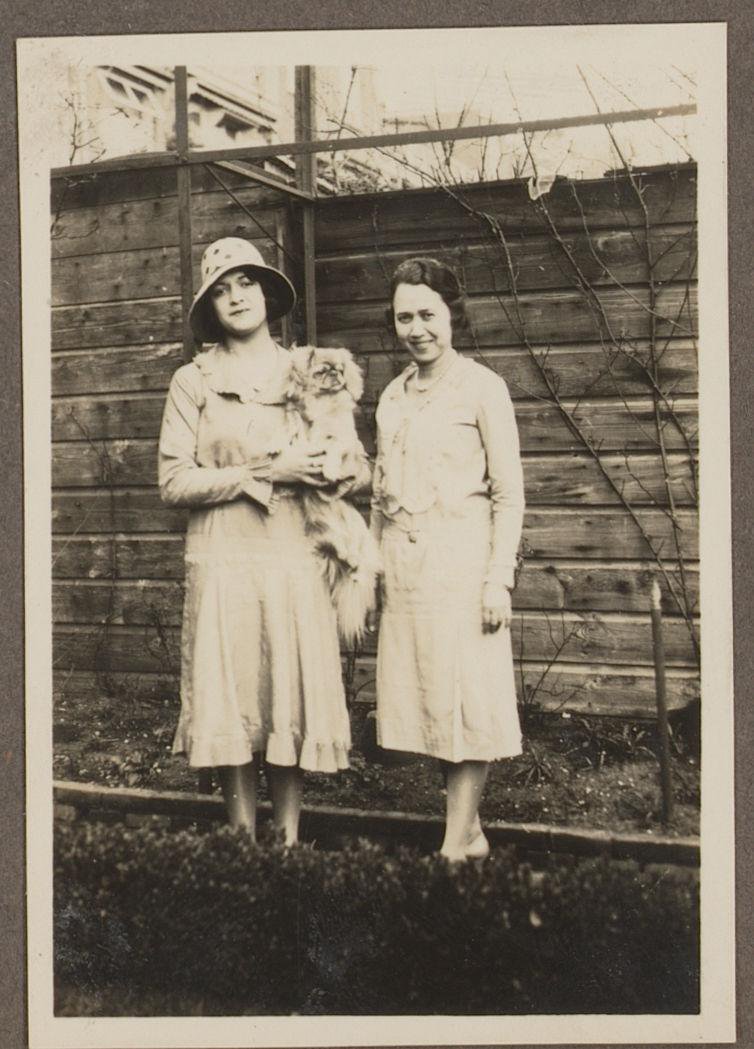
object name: photograph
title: Portret van Henriëtte Wassink en Sophia Josephina Kijdsmeir met een hond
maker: Anonymous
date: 1930-1935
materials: paper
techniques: gelatin silver print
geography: netherlands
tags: batavia, the hague, henriëtte wassink, historical persons - bb - woman, dog, netherlands